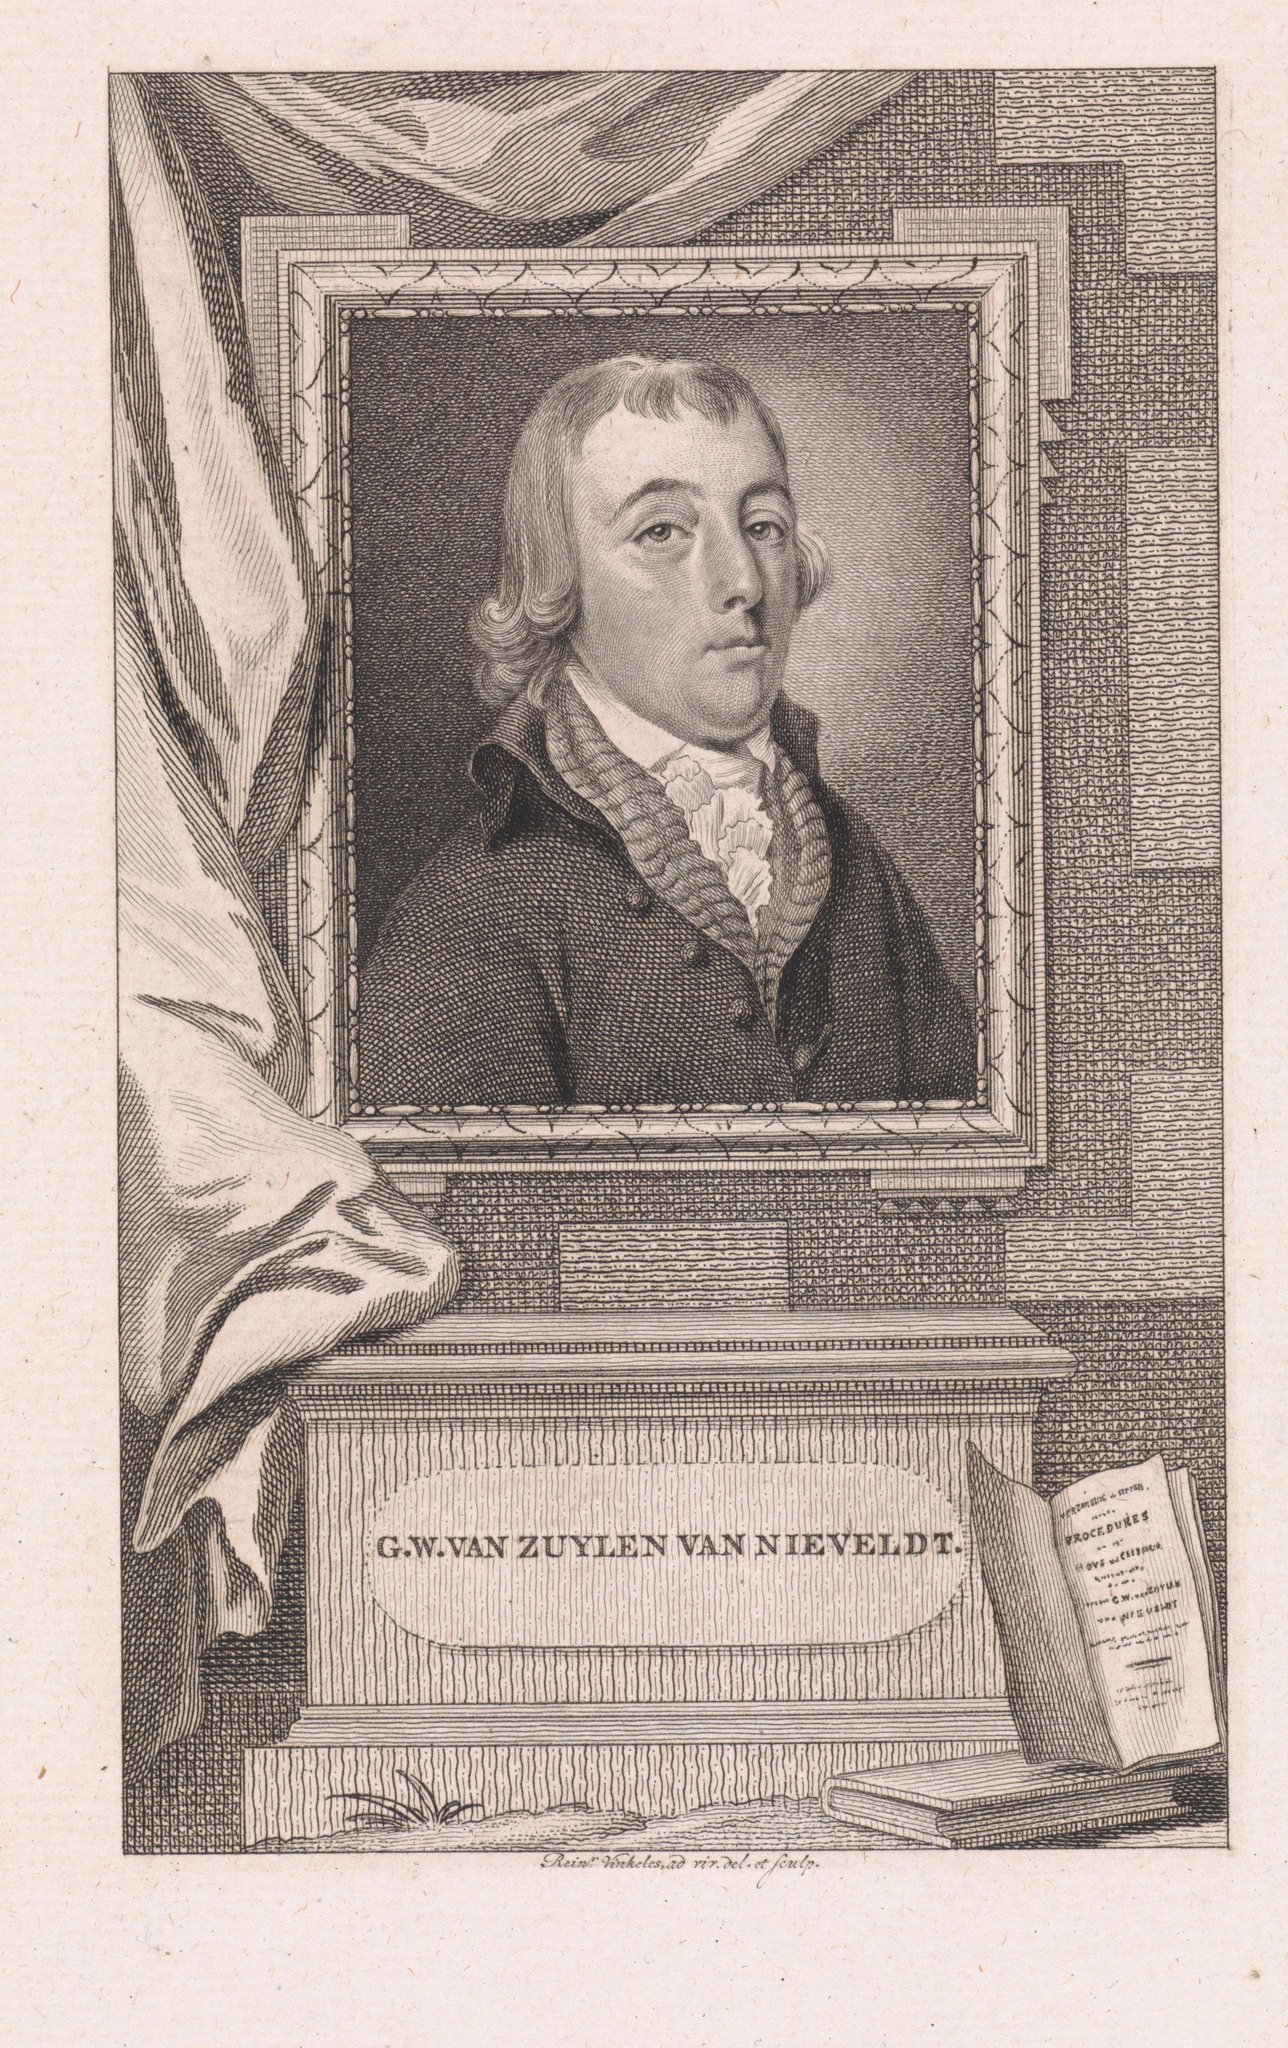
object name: print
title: Portret van Gerrit Willem van Zuylen van Nievelt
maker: reinier vinkeles (i)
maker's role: draughtsman, print maker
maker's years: 1741-1816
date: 1786-1809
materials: paper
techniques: engraving, etching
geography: amsterdam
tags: arnhem, pamphlet ~ printed matter - mm - book open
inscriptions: collector's mark: Lugt 2228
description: Prent ook gebruikt als boekillustratie in: Wagenaar, Jan. Vaderlandsche historie, (...) ten vervolge van Wagenaars Vaderlandsche historie. Dl. 1-43. Amsterdam: Johannes Allart, 1786-1809.